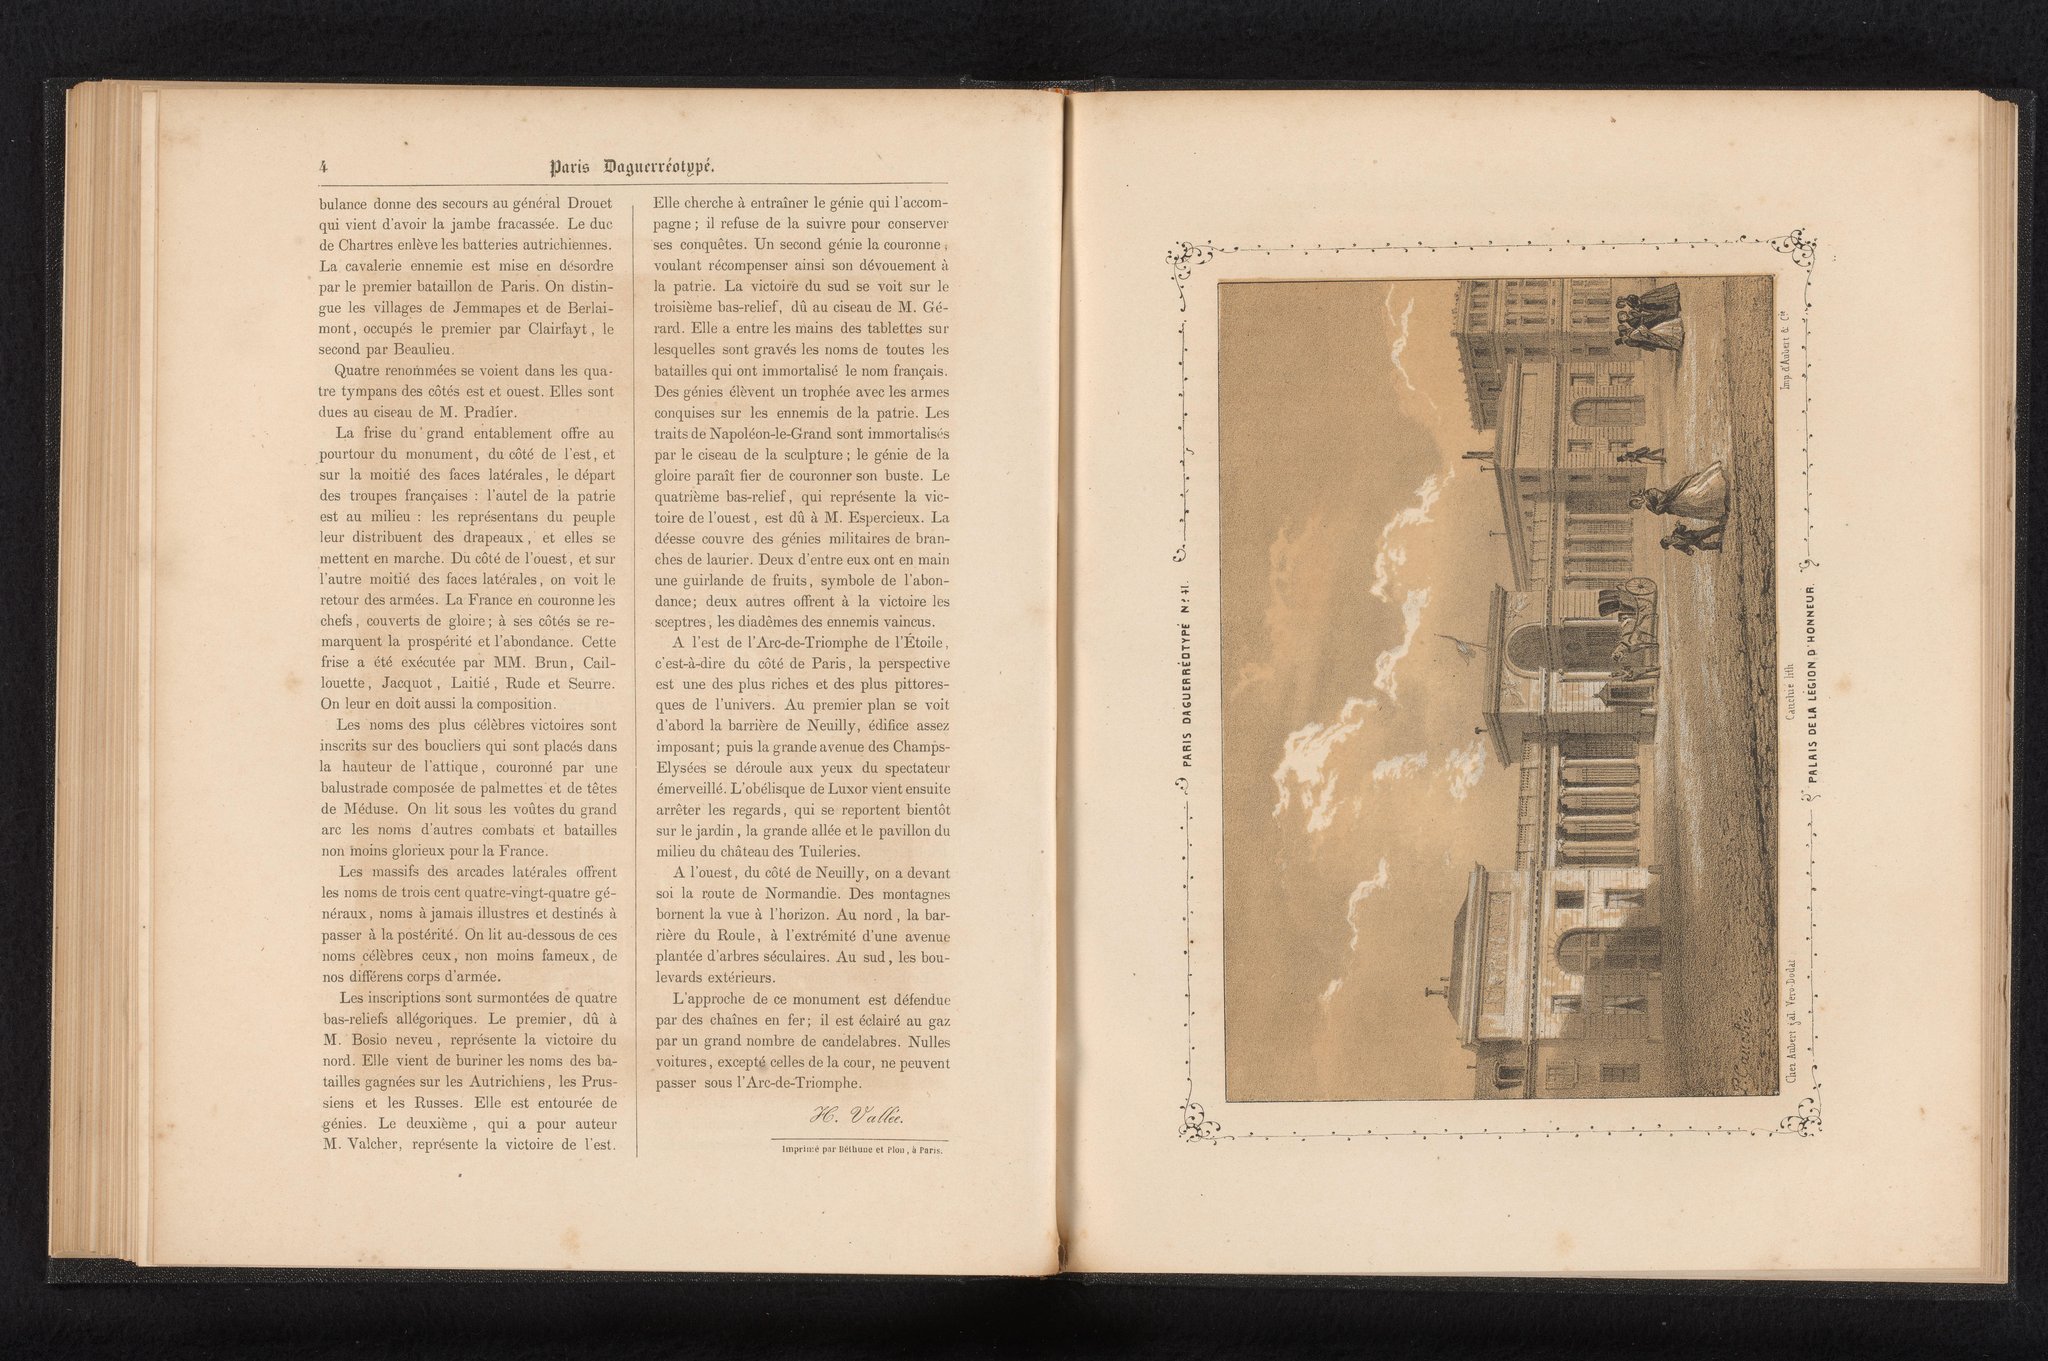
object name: print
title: Palais de la Légion d'honneur in Parijs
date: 1839-1840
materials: paper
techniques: tone lithography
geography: paris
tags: palace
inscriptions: inscription: ‘PARIS DAGUERRÉOTYPÉ No. 41.’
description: Prent op honderddrieënzestigste ongenummerde pagina.